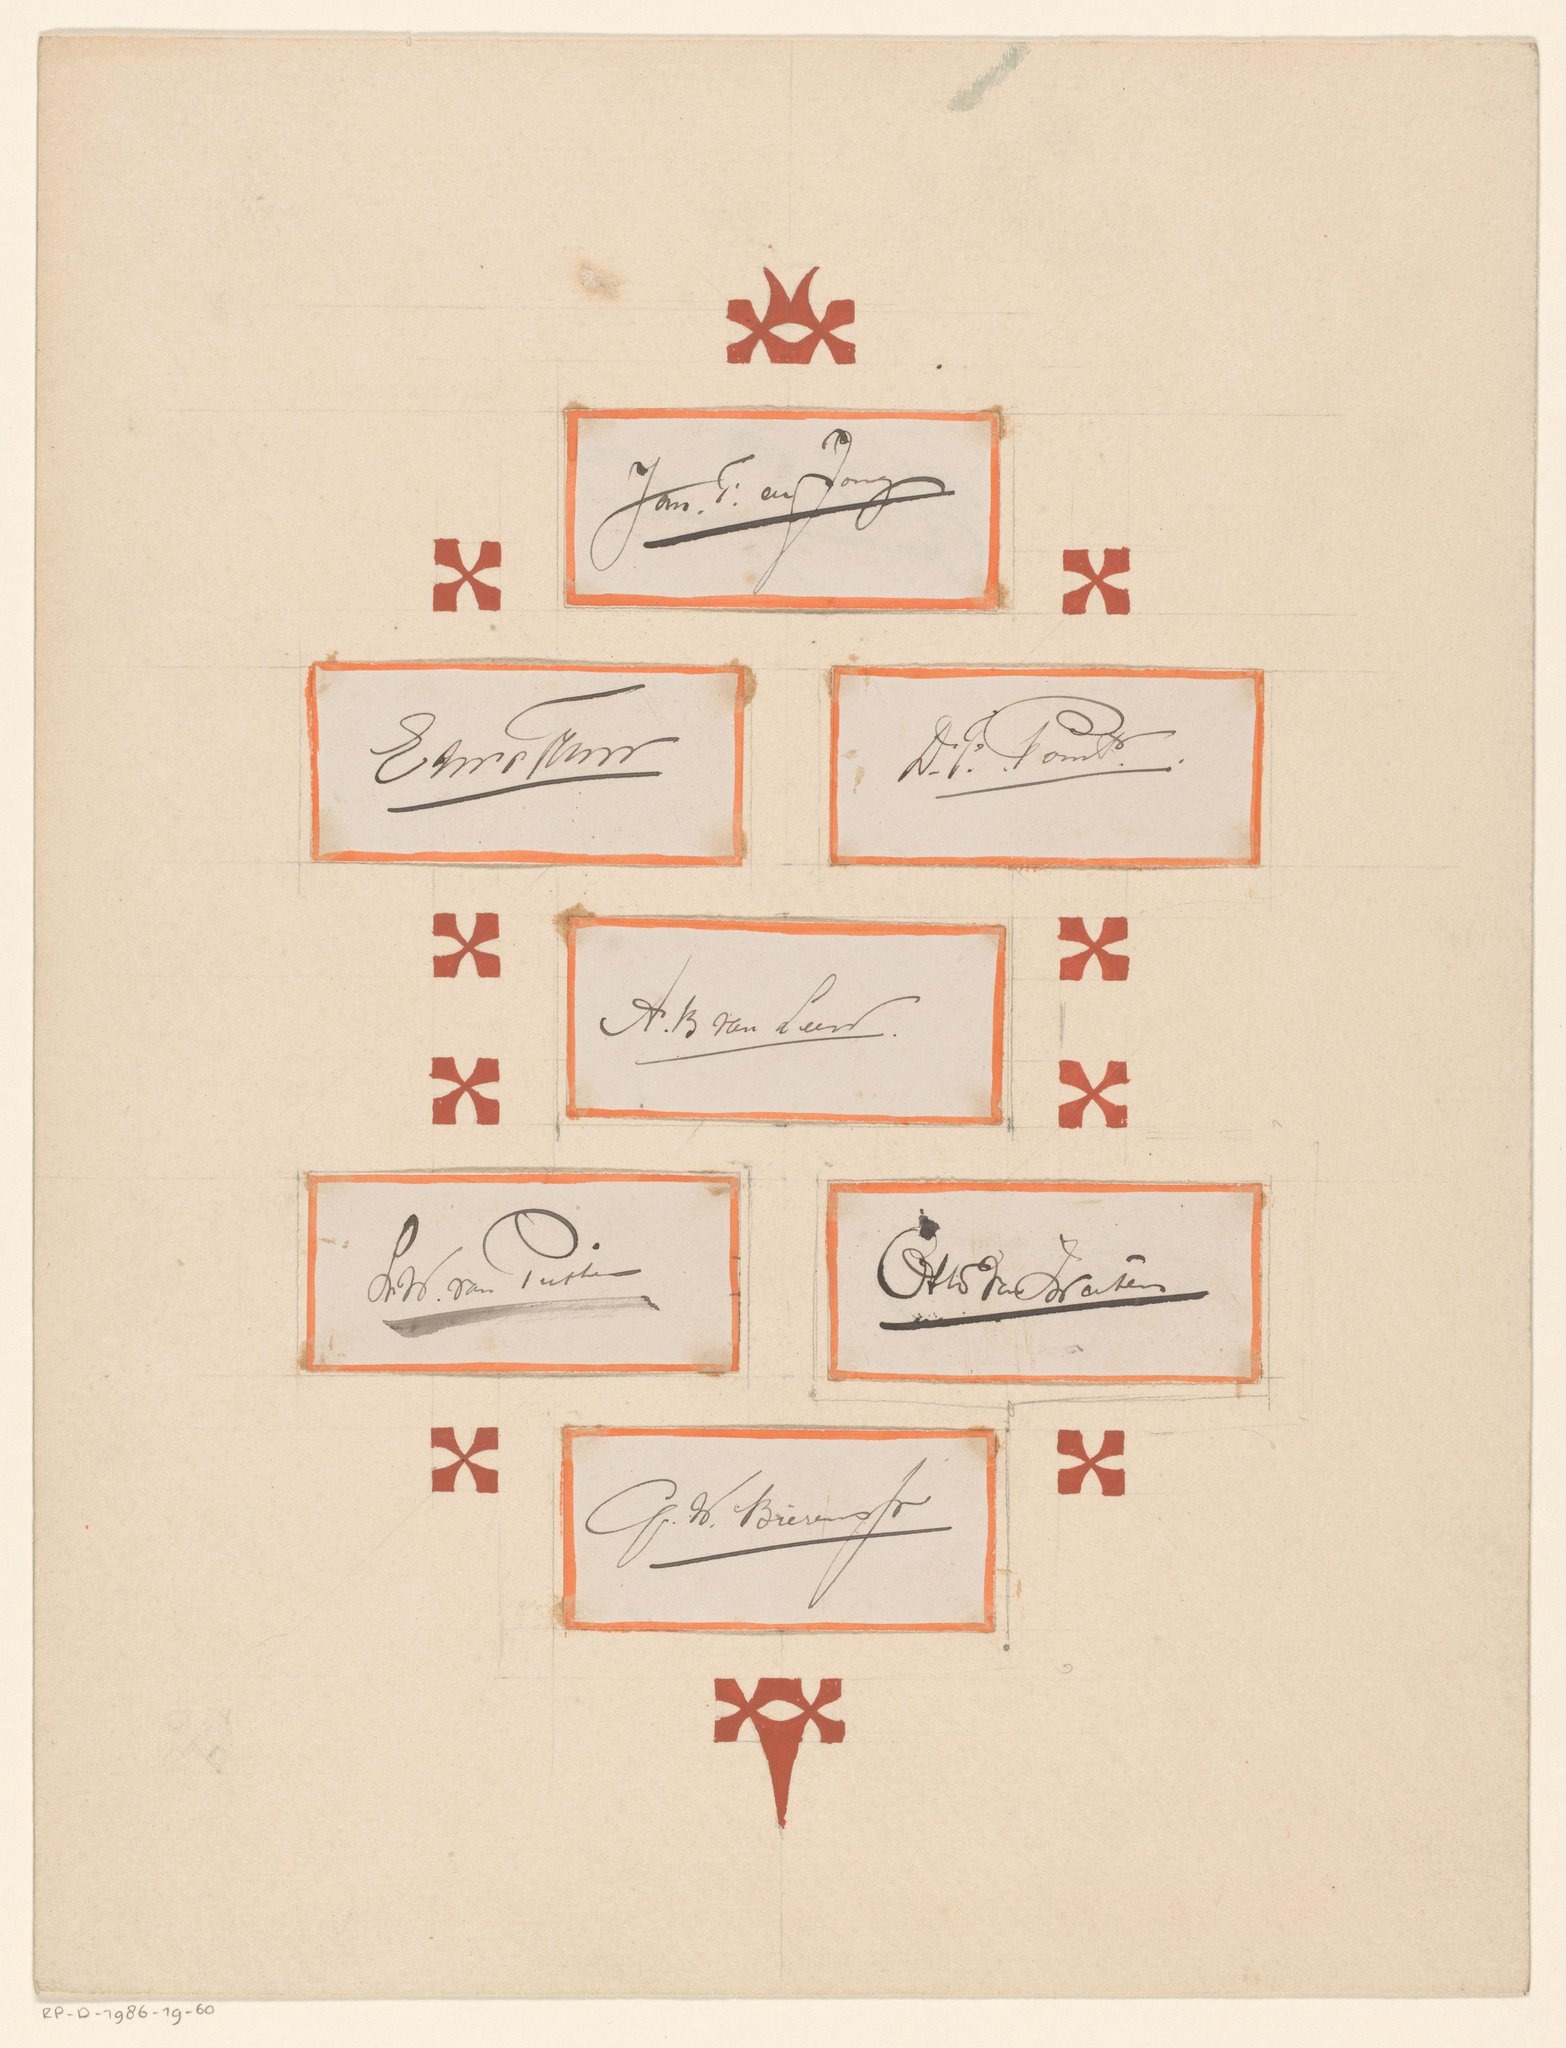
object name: drawing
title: Blad met zeven handtekeningen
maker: reinier willem petrus de vries (1874-1953)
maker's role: draughtsman, print maker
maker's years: 1874-1953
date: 1901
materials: ink, paint, paper, pencil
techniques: brush, pen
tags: leiden, publisher, albertus willem sijthoff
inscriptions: collector's mark: ‘R:MVS.’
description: Ontwerp voor een album voor A.W. Sijthoff ter gelegenheid van zijn vijftigjarige uitgeversloopbaan.